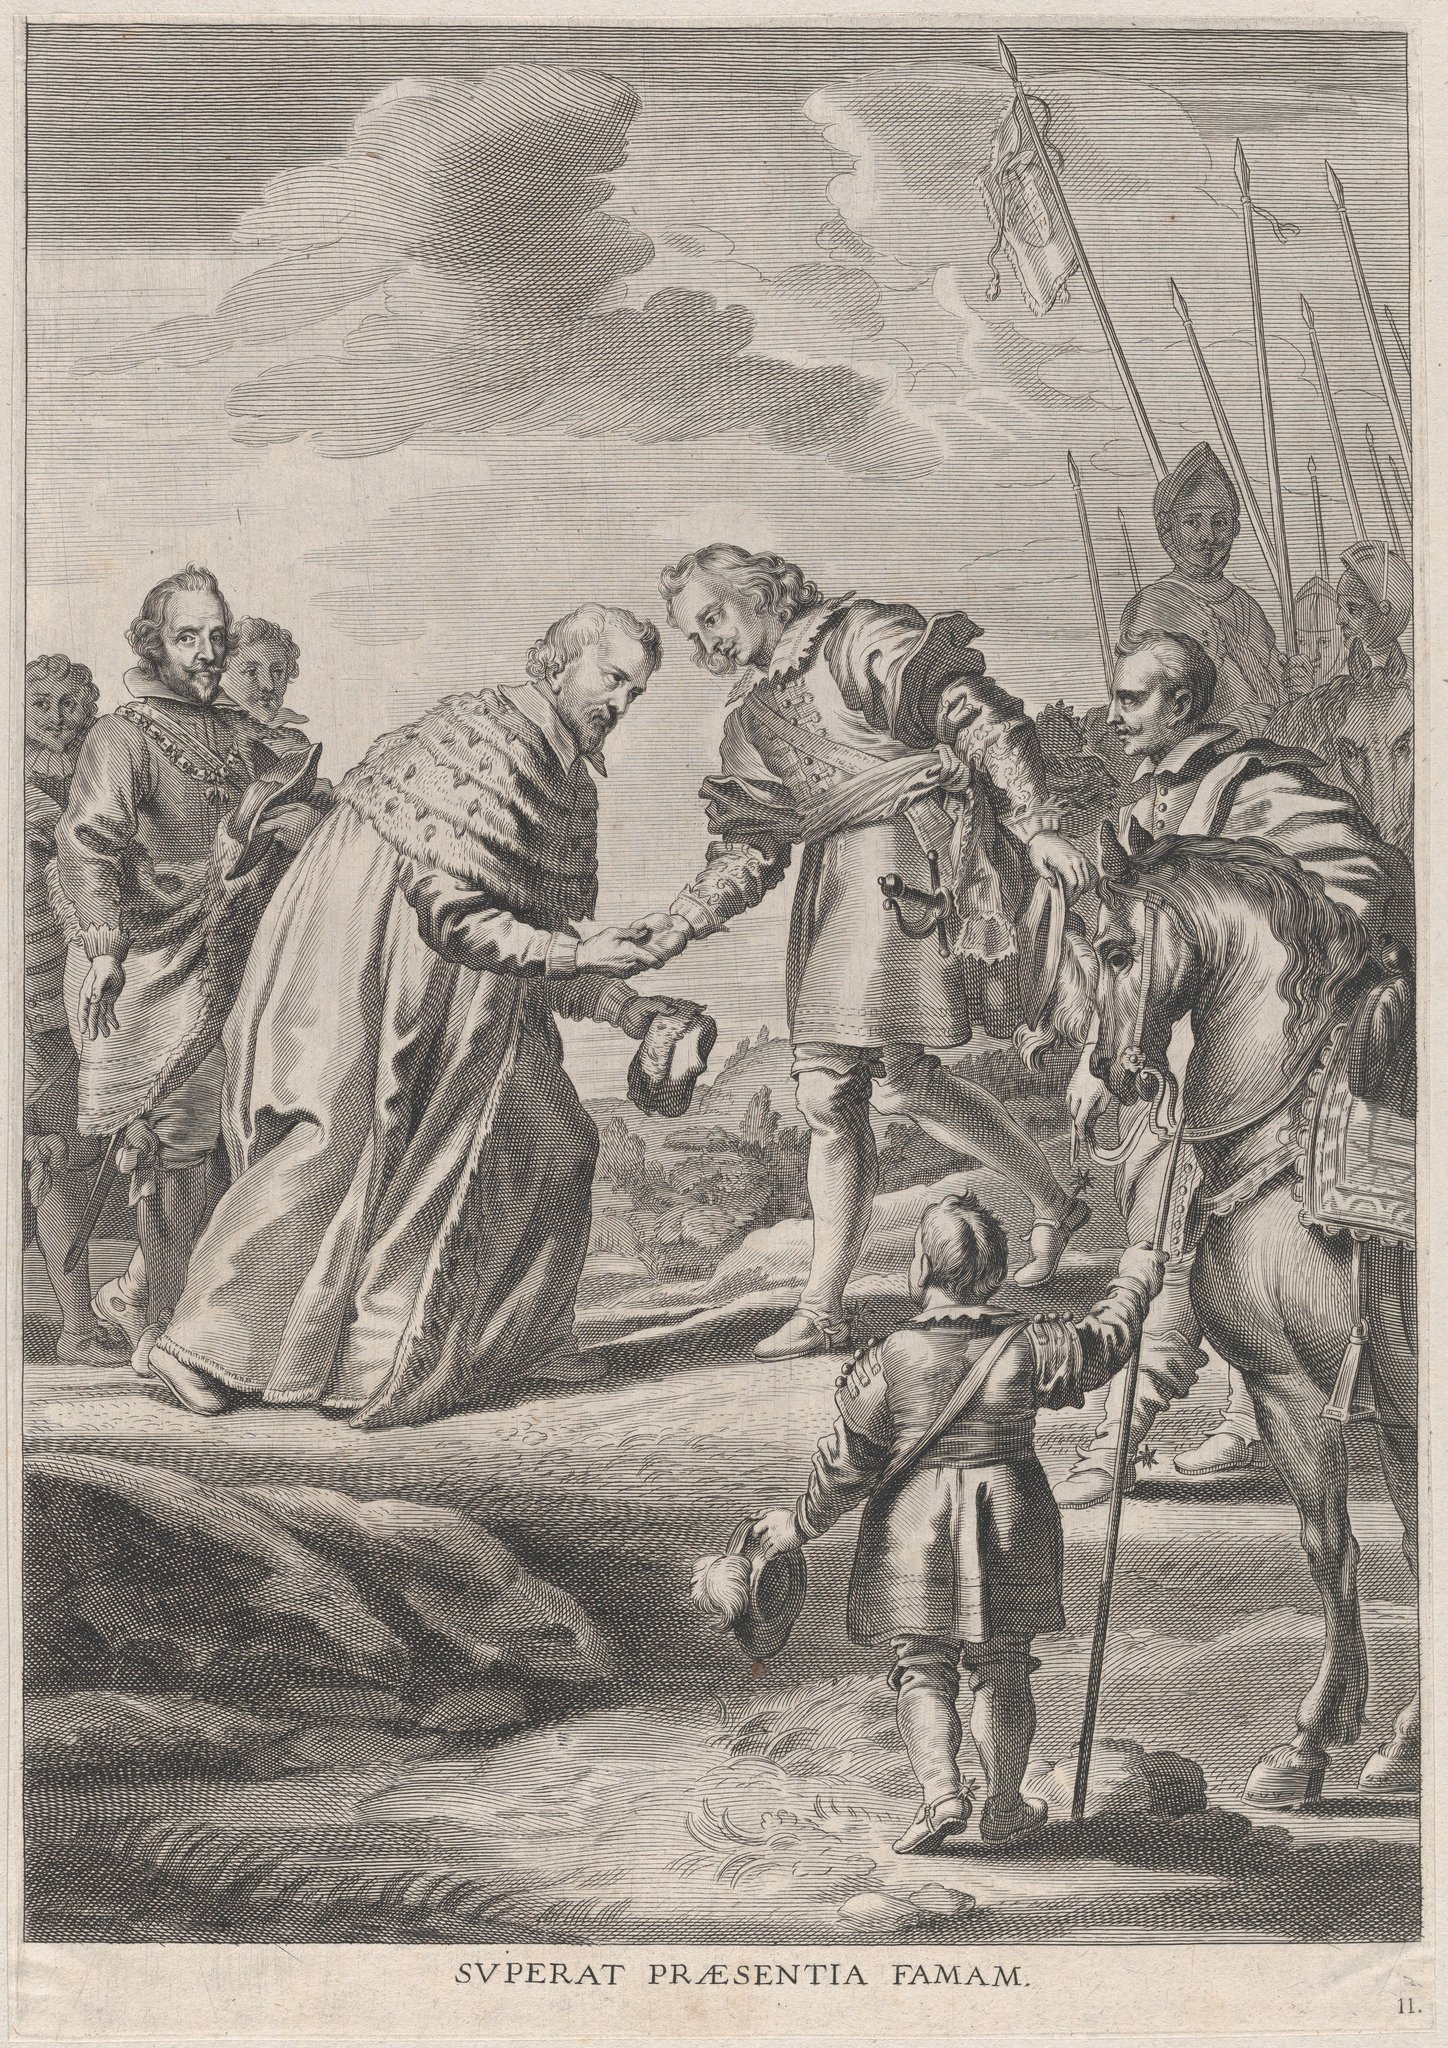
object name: print, fete, ornament architecture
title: Plate 11: Ferdinand greeted by the Elector of Cologne; from Guillielmus Becanus's 'Serenissimi Principis Ferdinandi, Hispaniarum Infantis...'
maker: pieter de jode (ii)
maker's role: artist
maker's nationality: flemish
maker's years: 1606-1674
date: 1636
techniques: engraving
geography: antwerp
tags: spears,men,horses